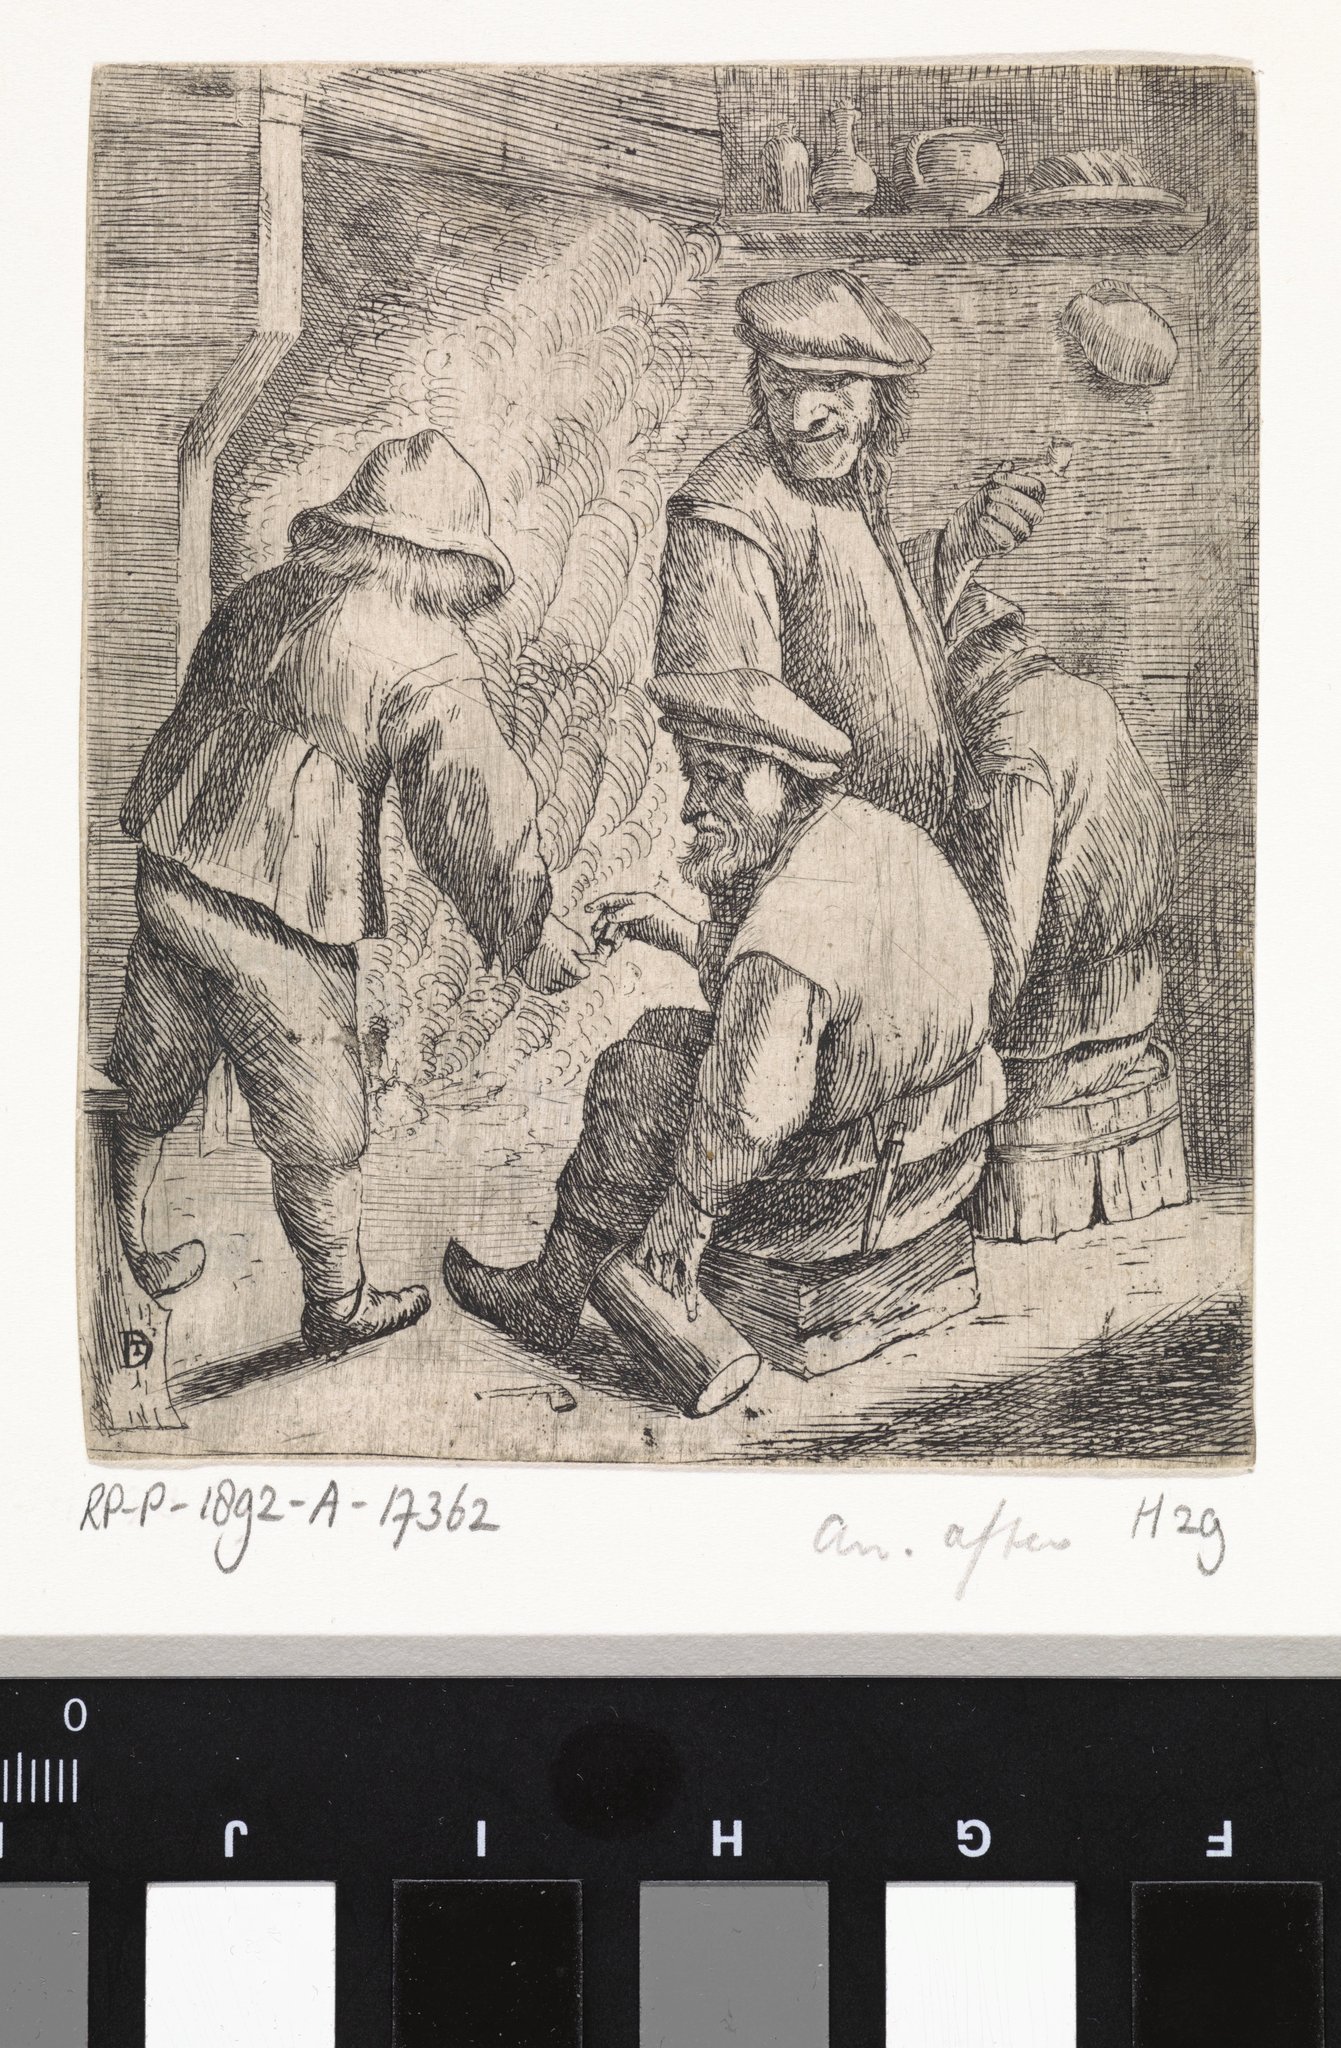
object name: print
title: Vier boeren bij een haardvuur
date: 1626-1740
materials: paper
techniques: etching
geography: low countries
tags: pipe ~ tobacco, open hearth, fire-place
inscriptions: collector's mark: Lugt 514, collector's mark: Lugt 2228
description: Vier boeren met hun pijpjes bij het haardvuur.